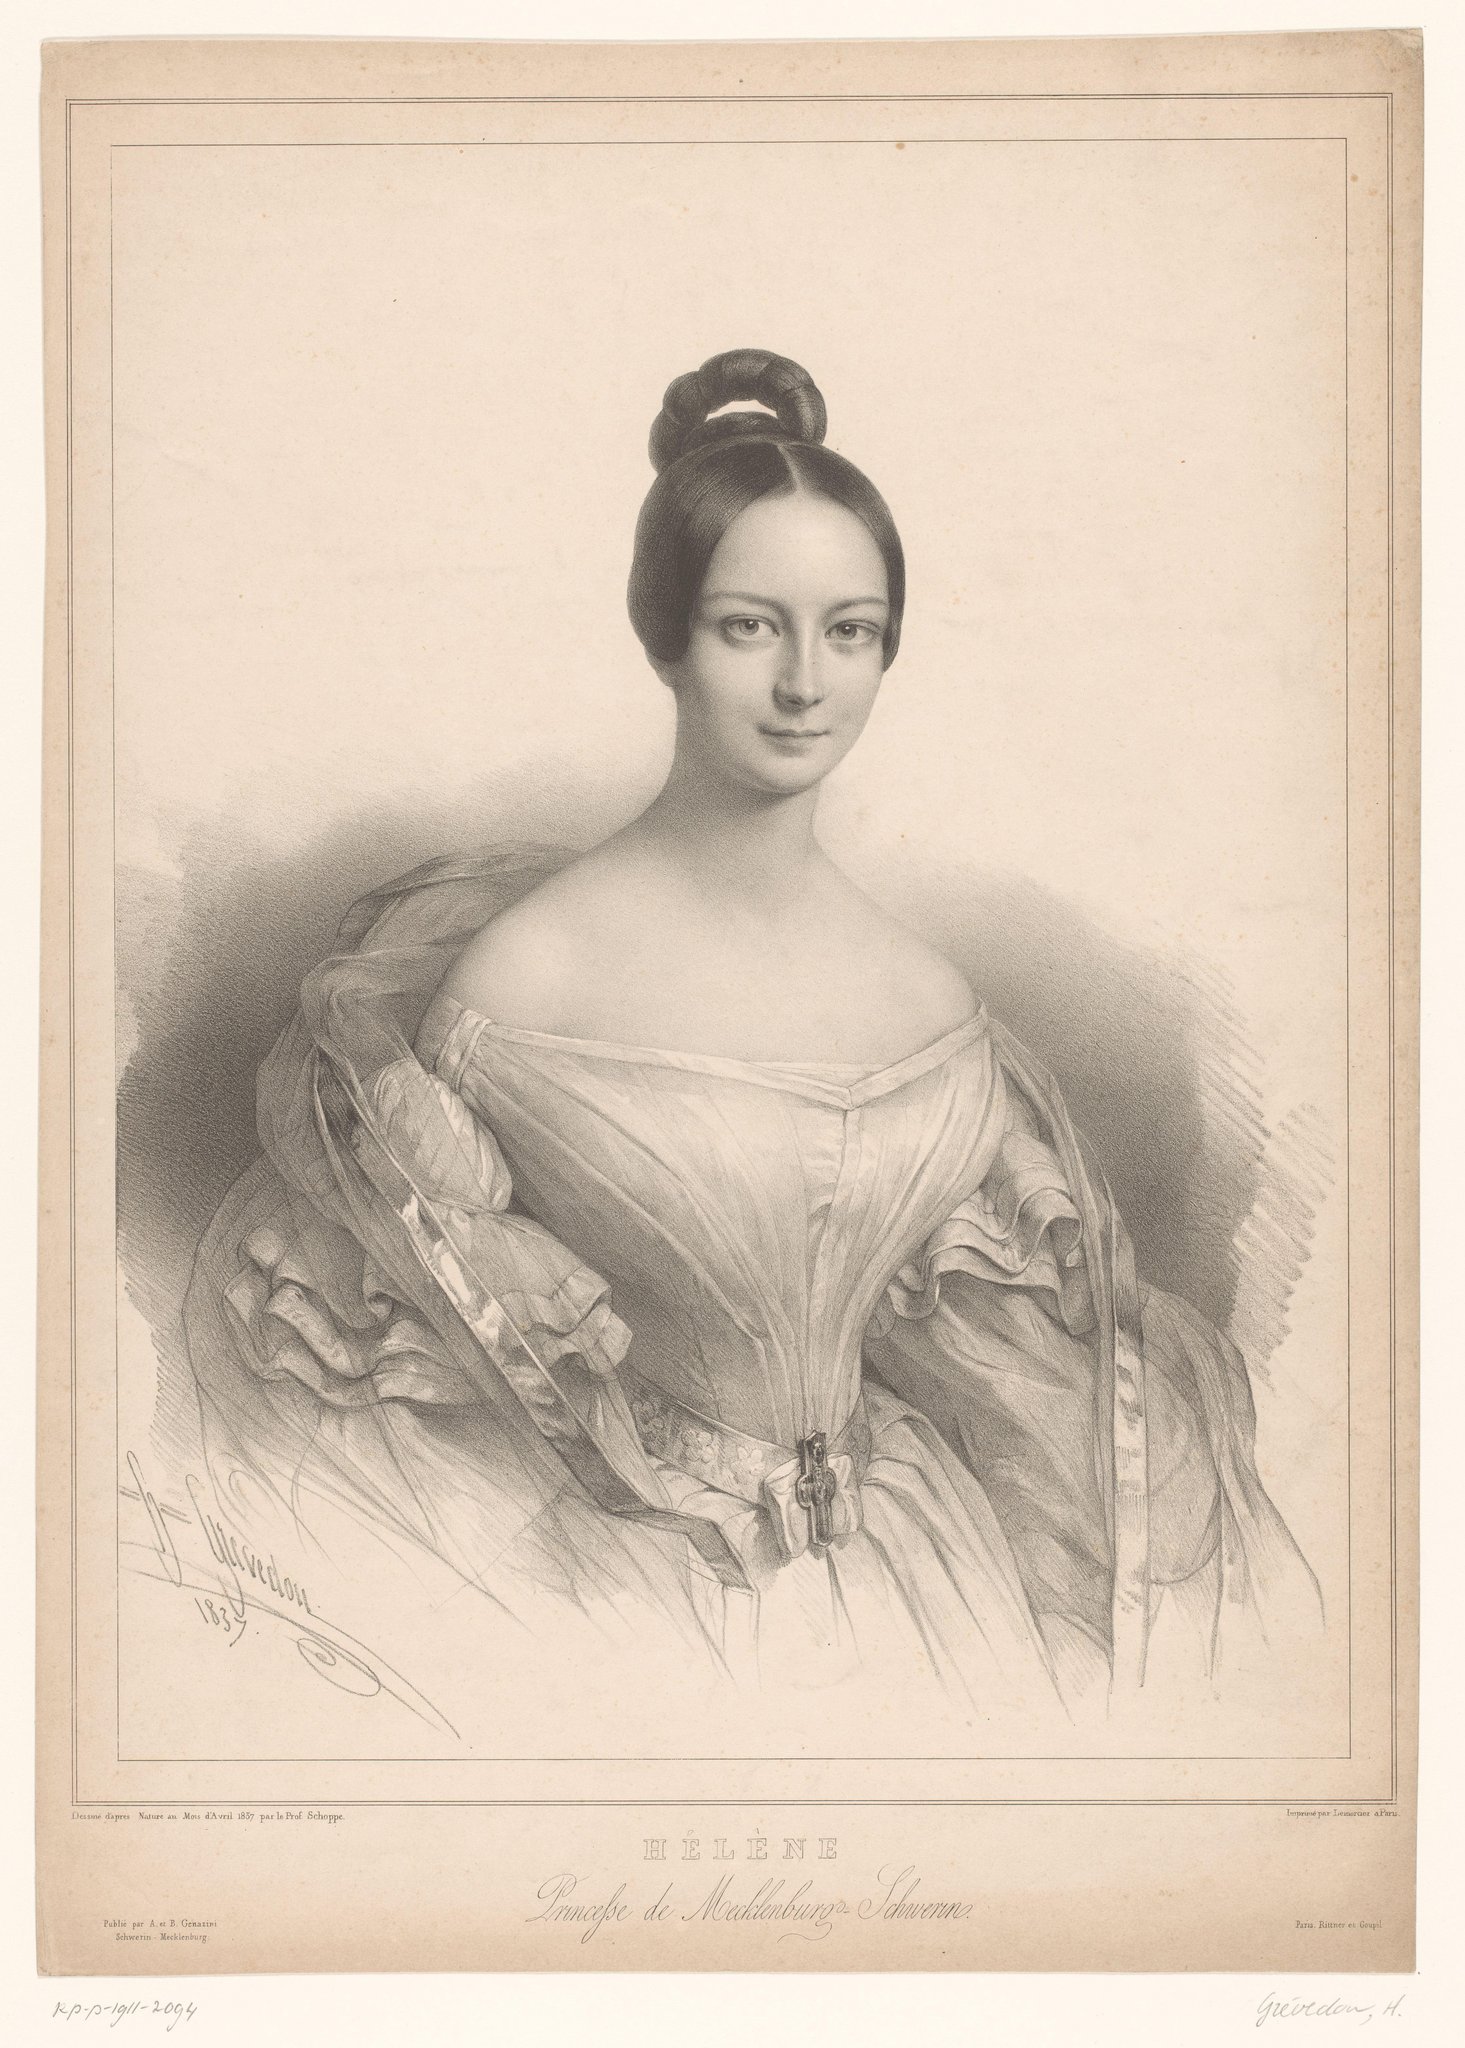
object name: print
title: Portret van Helena van Mecklenburg-Schwerin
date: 1837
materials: paper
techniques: lithograph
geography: paris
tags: helene van mecklenburg-schwerin, historical persons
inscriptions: collector's mark: Lugt 2228a